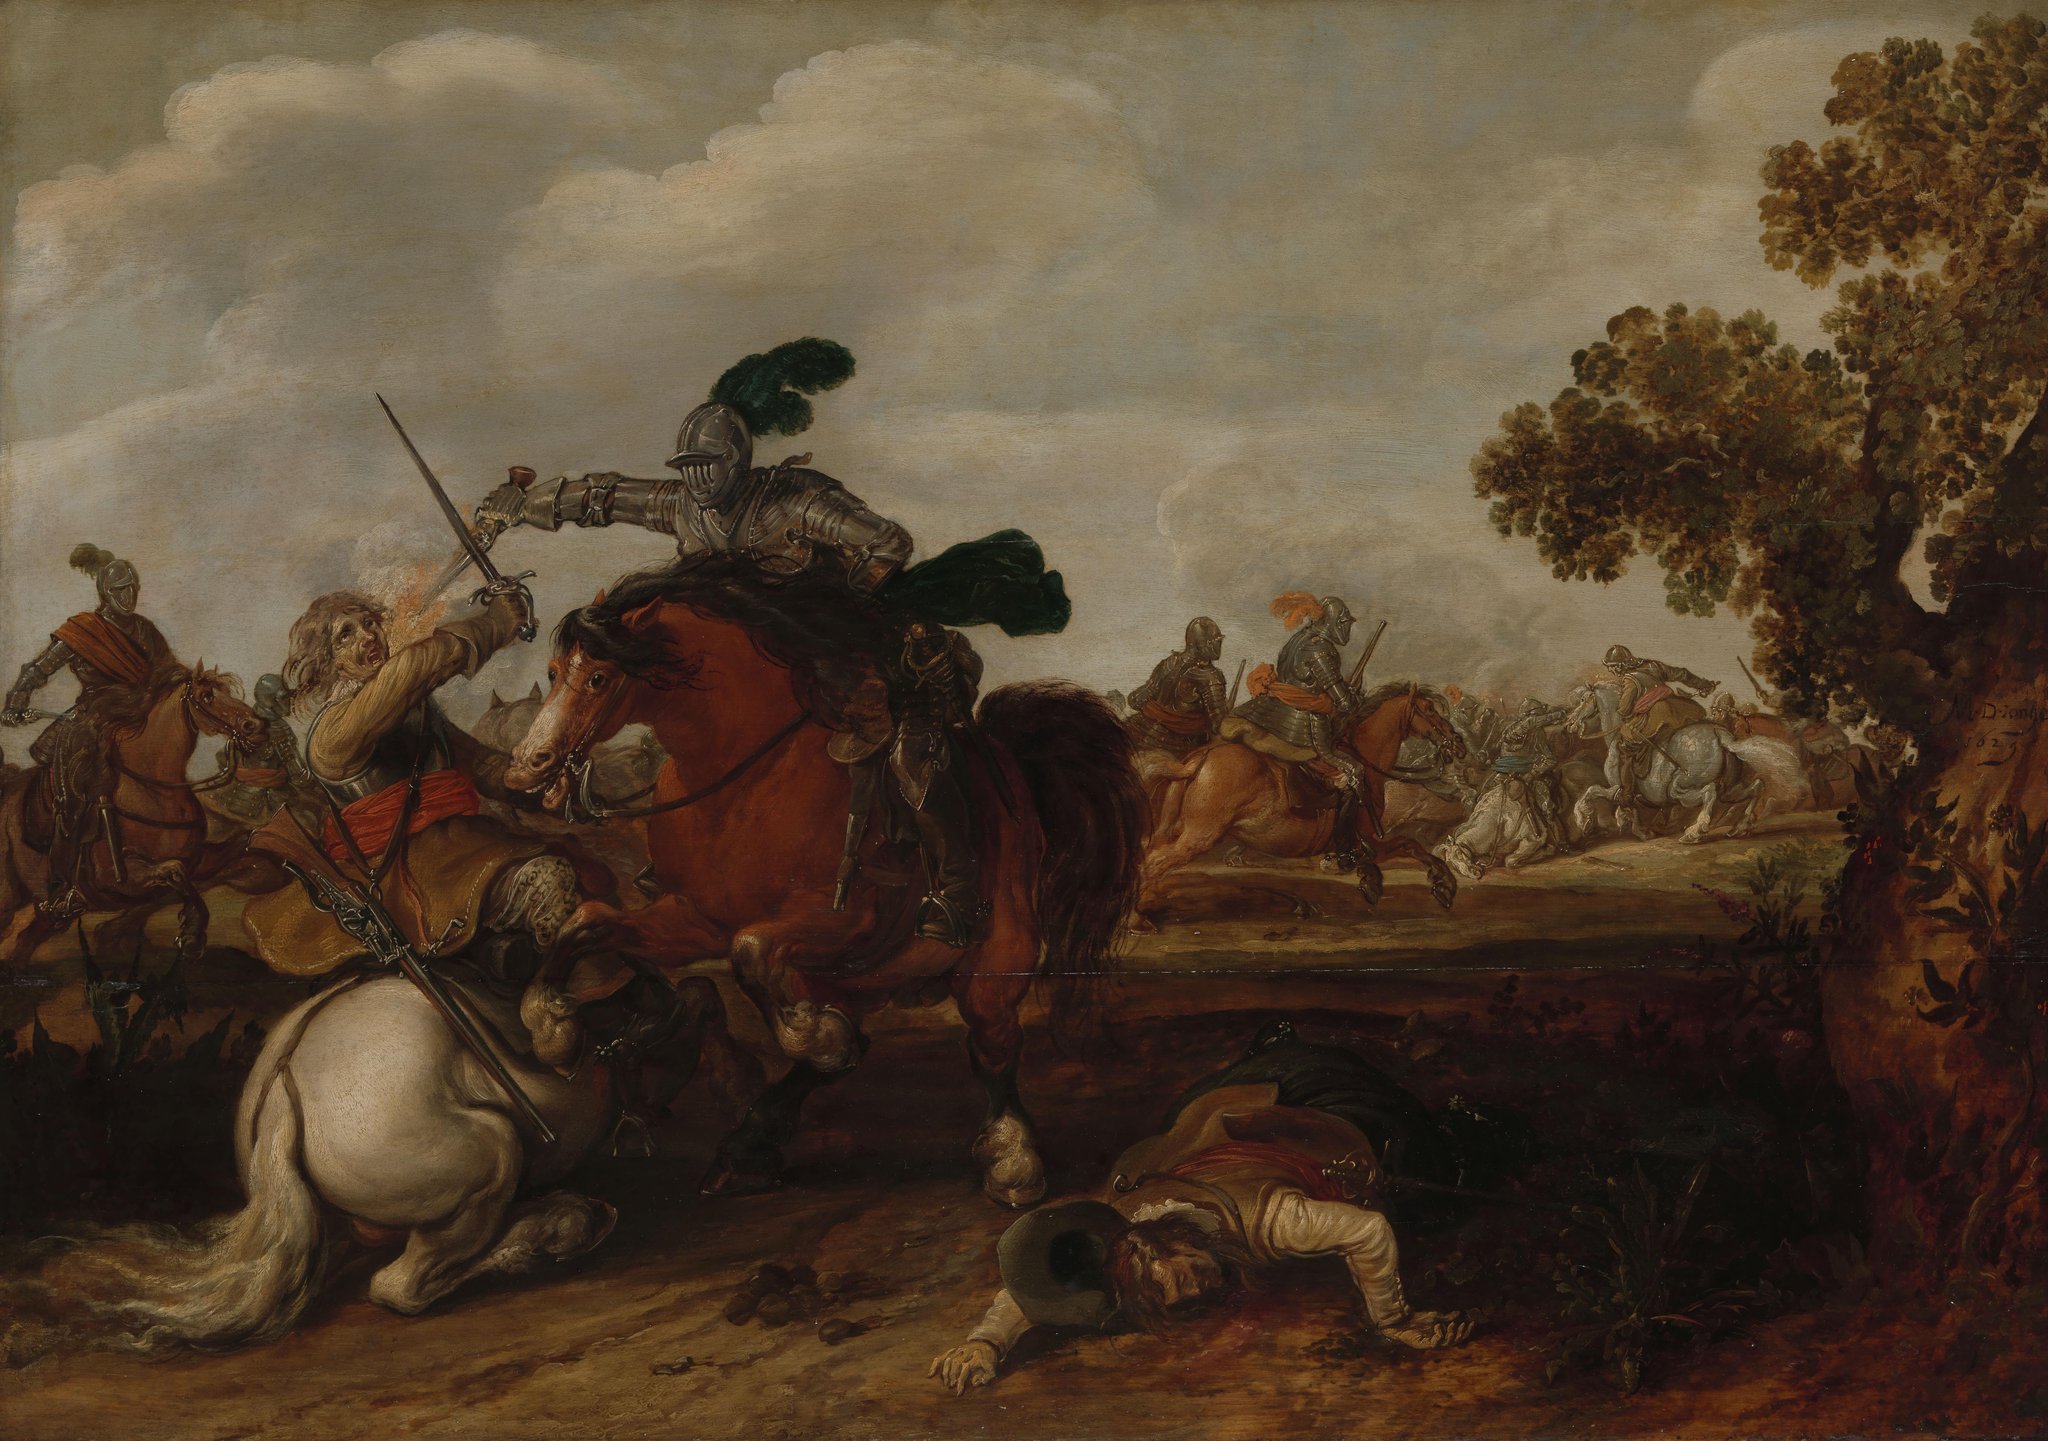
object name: painting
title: A Cavalry Charge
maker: jan martszen de jonge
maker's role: draughtsman, painter, print maker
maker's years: 1609-1647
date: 1629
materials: oil, panel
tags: horse throwing rider, battle, fighting in general (+ cavalry, horsemen)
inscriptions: signature and date: ‘IM. D. Ionge 1629’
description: Ruitergevecht. Een ruiter in wapenrusting schiet met zijn pistool op een ruiter op een wit paard. Op de voorgrond ligt het lichaam van een gesneuvelde man, op de achtergrond woedt de veldslag.